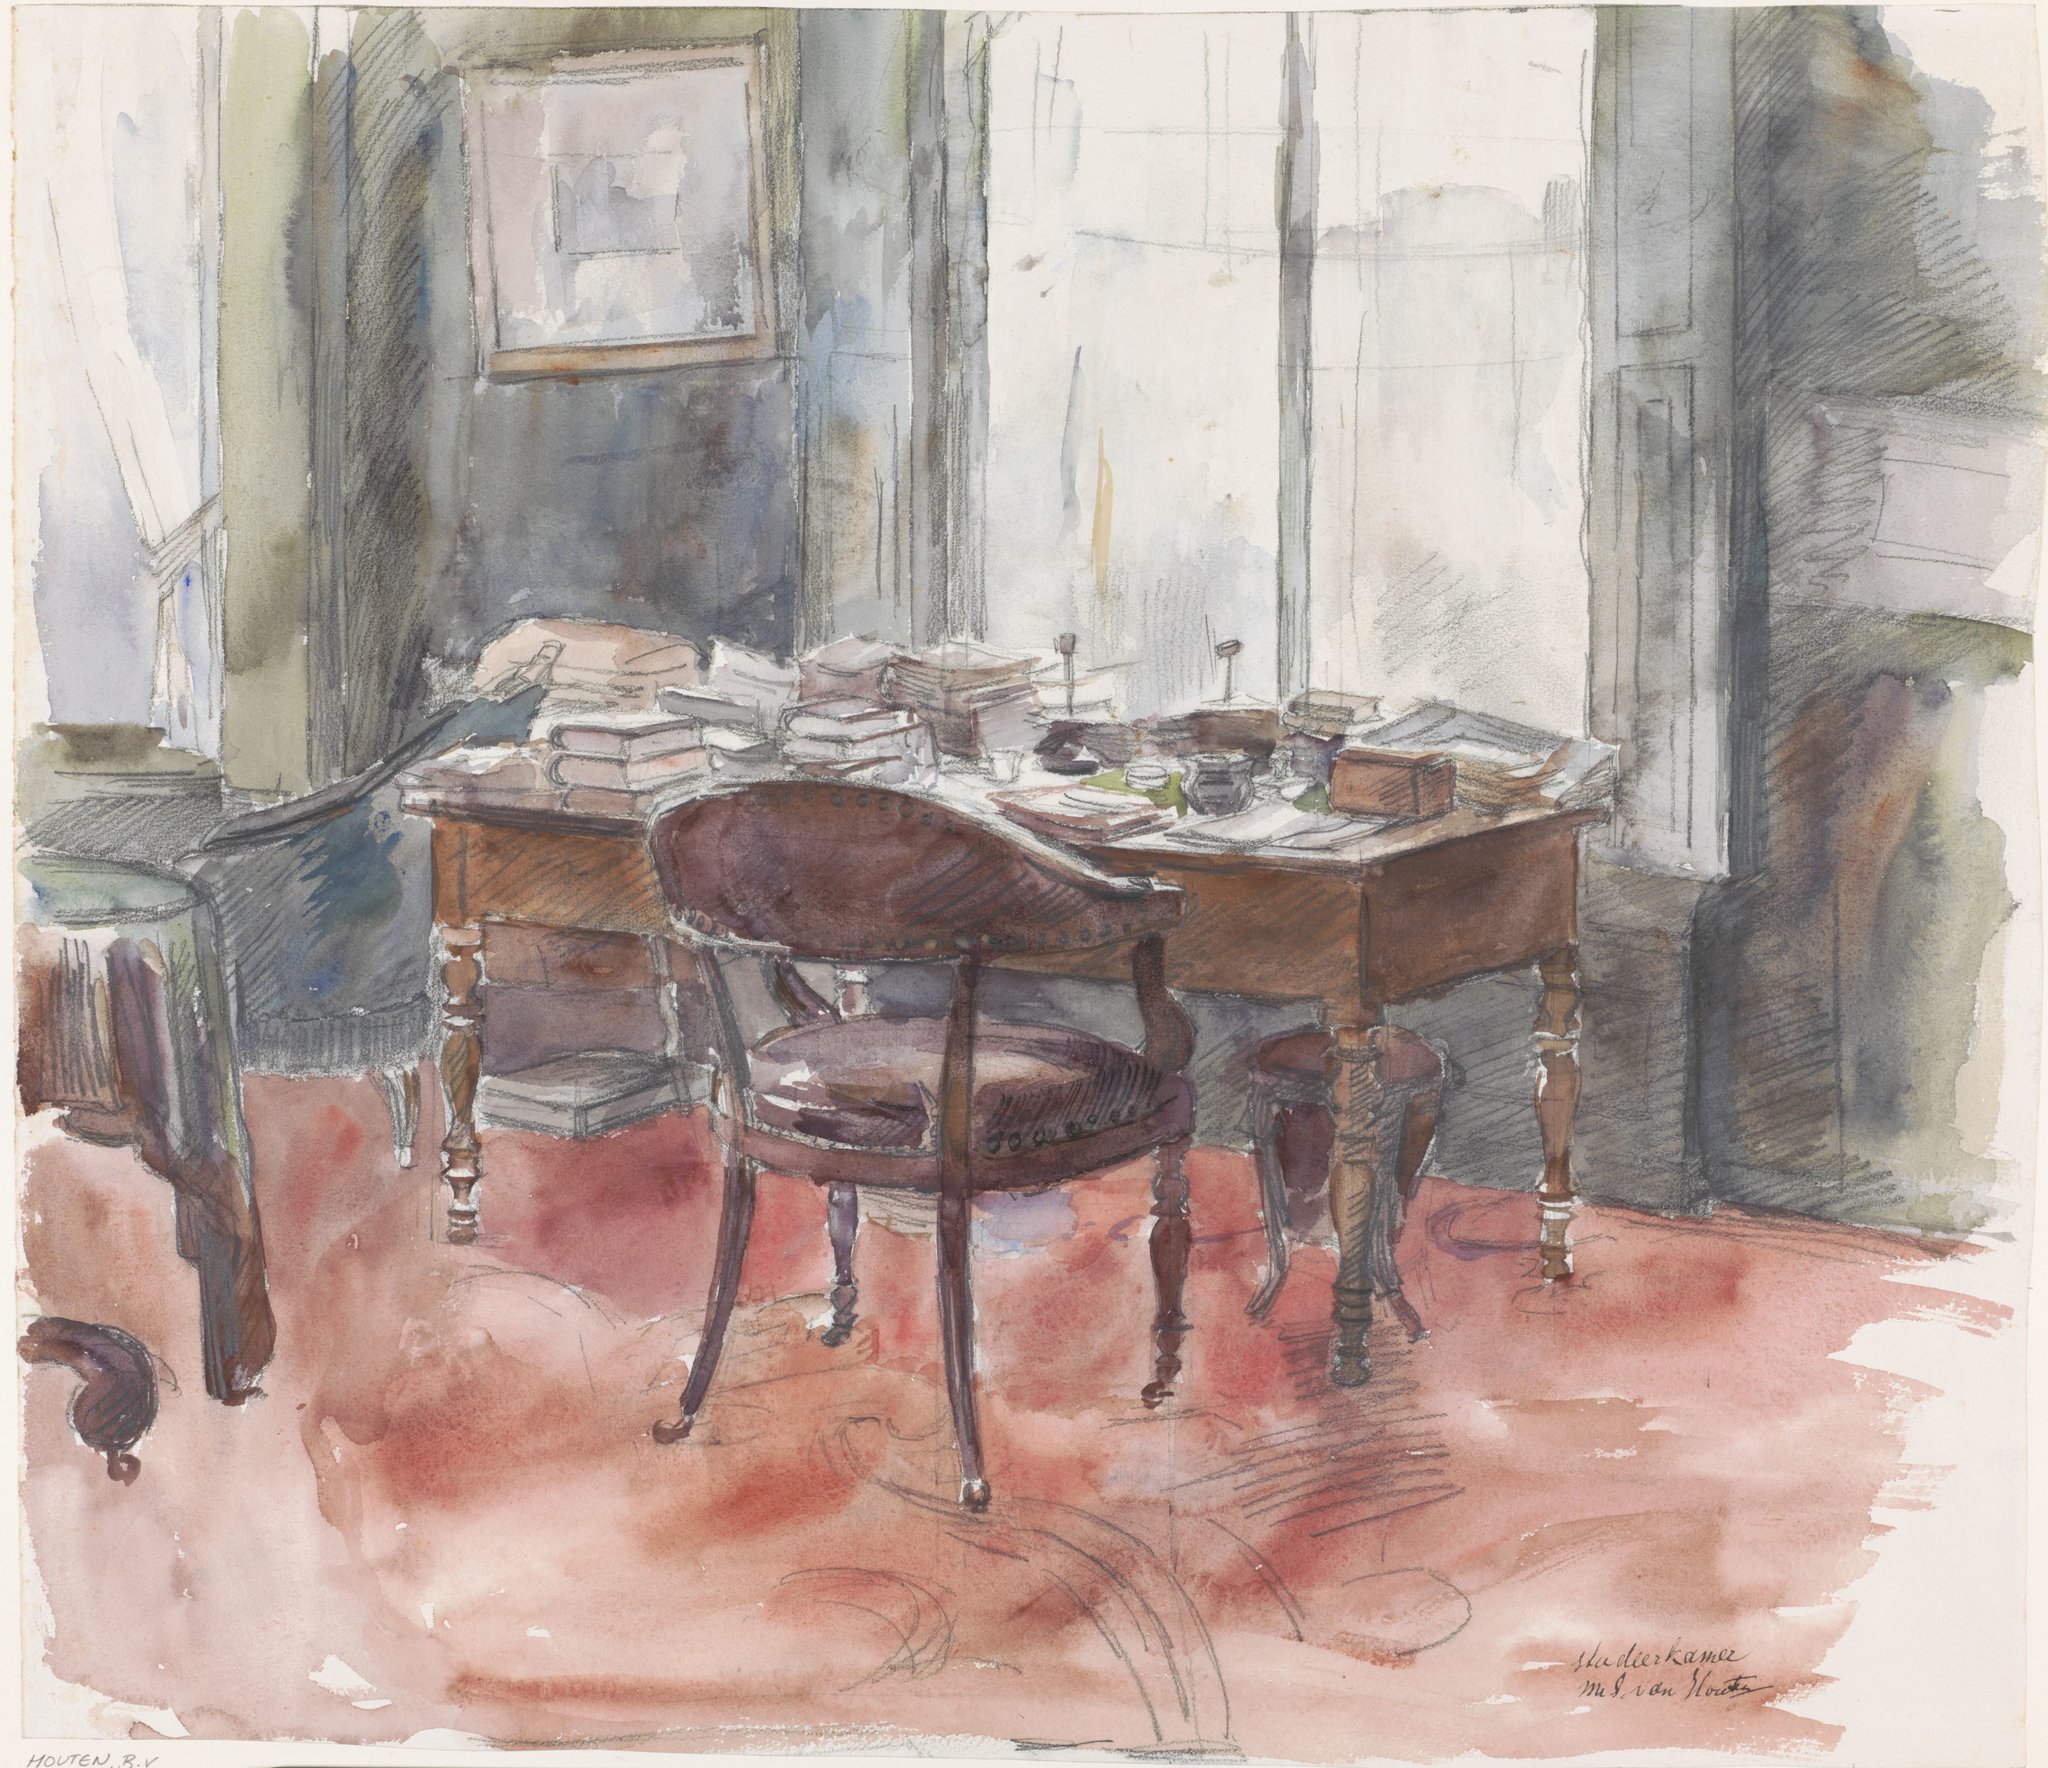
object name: watercolor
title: Het bureau in de studeerkamer van meneer S. van Houten, in het huis aan de Riouwstraat 6, te Den Haag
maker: barbara elisabeth van houten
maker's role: draughtsman, print maker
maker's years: 1862-1950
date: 1872-1950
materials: paper, pencil, watercolor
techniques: brush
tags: study; 'studiolo'; library, the hague